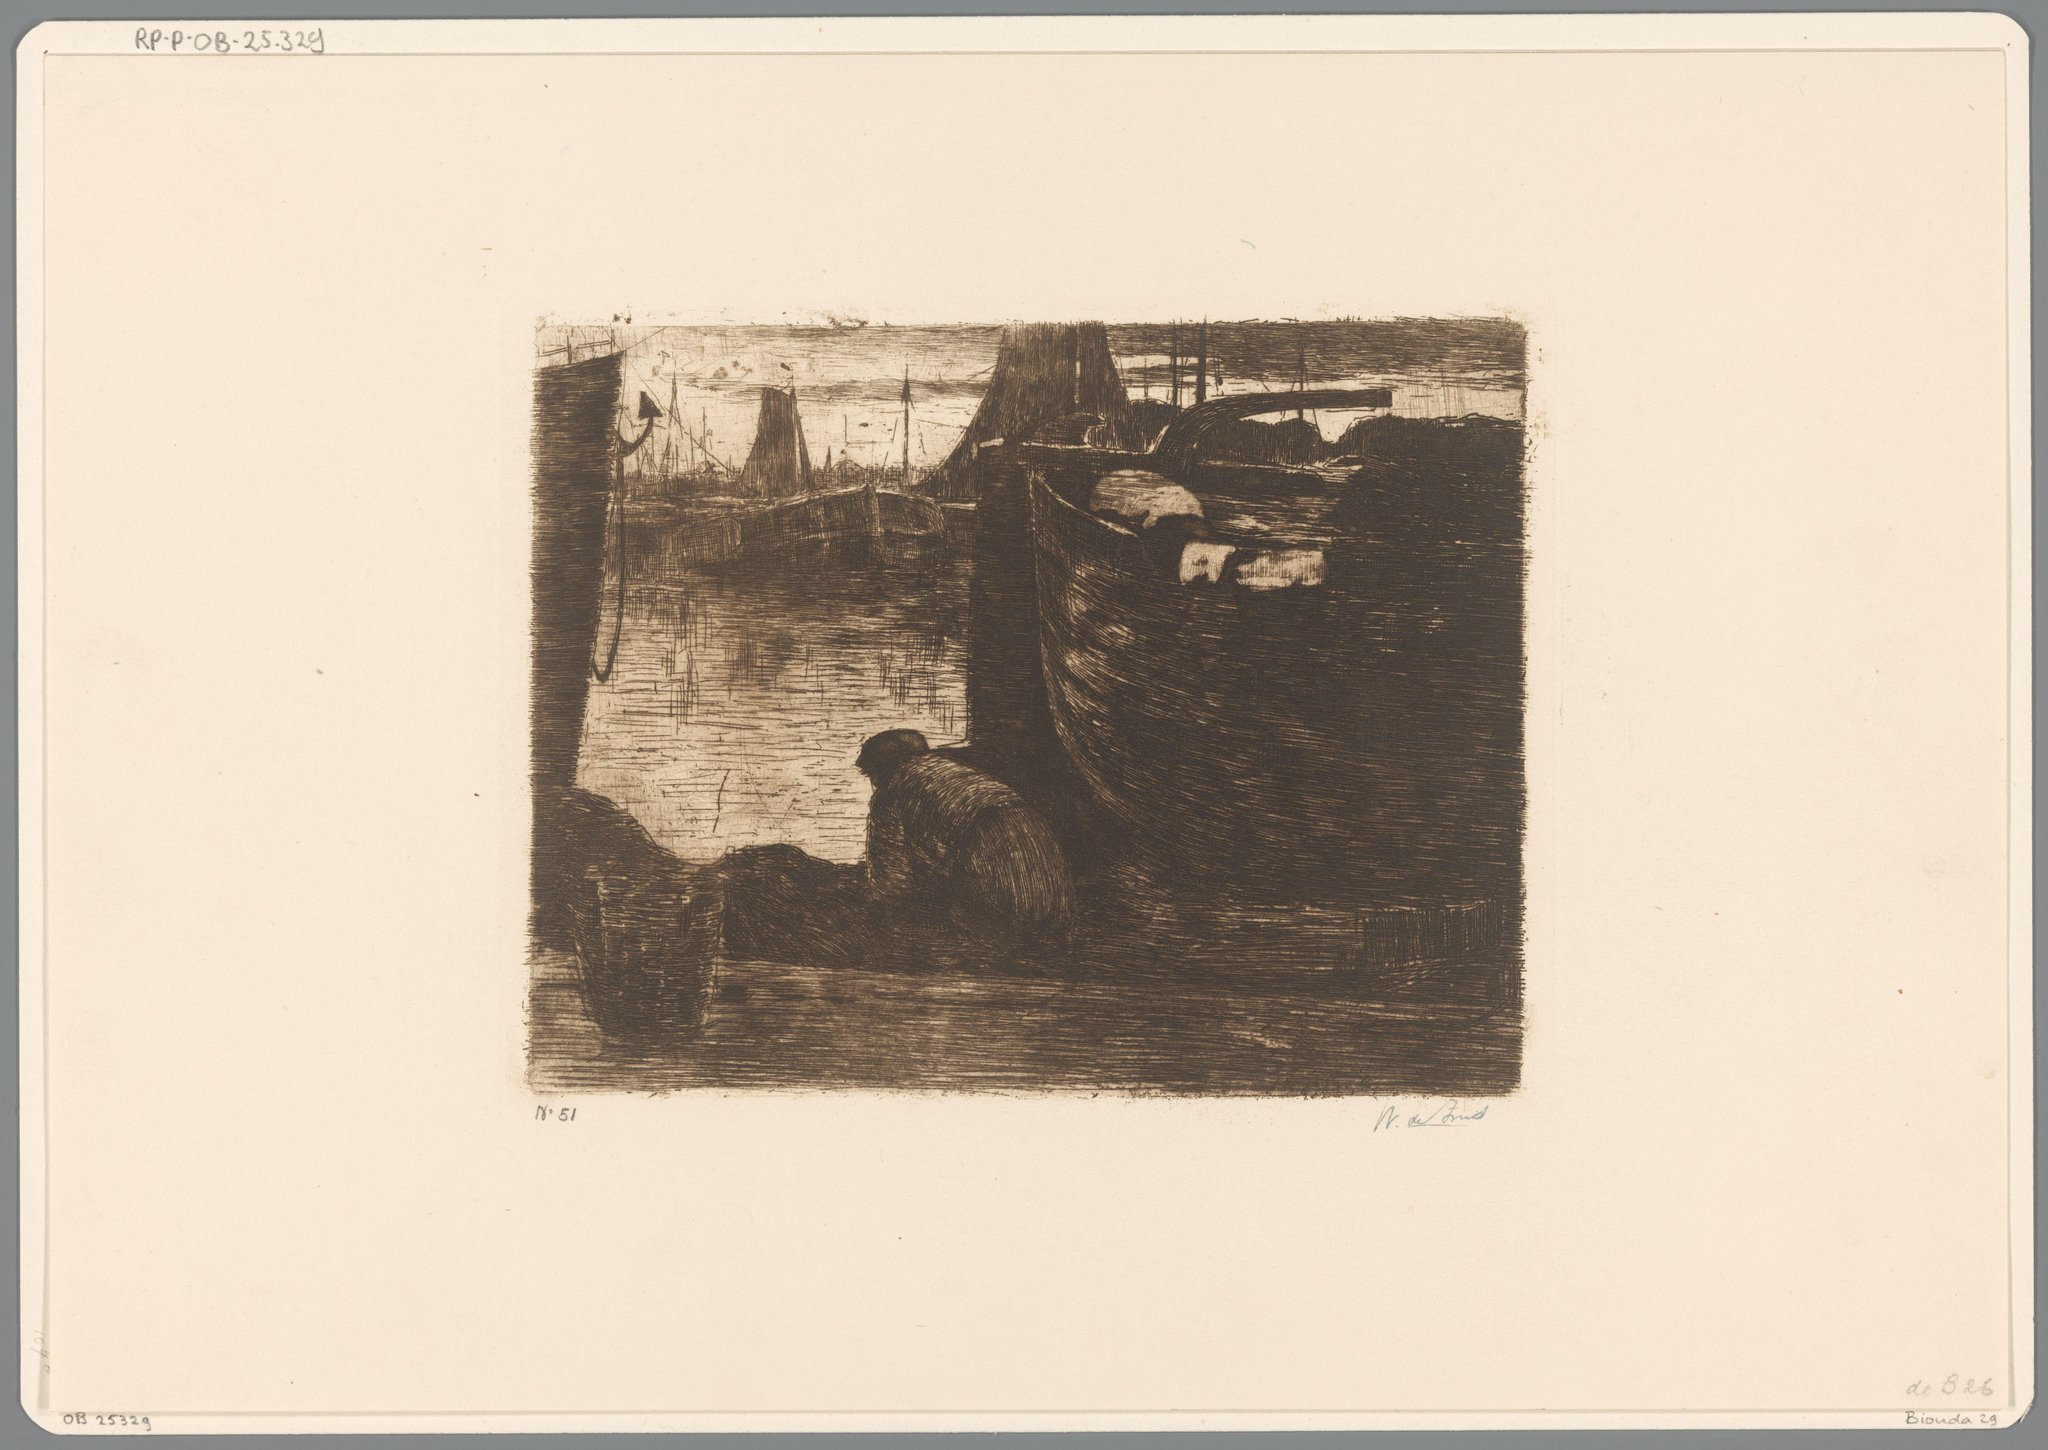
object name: print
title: Aan de kade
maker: willem de zwart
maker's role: draughtsman, painter, print maker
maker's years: 1862-1931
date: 1886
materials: paper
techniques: drypoint, etching, intaglio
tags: harbour, pier, quay, wharf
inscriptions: collector's mark: Lugt 2228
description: Prent verscheen in 1887 als onderdeel van de jaarlijkse uitgave van de 'Portefeuille der Nederlandsche Etsclub'.